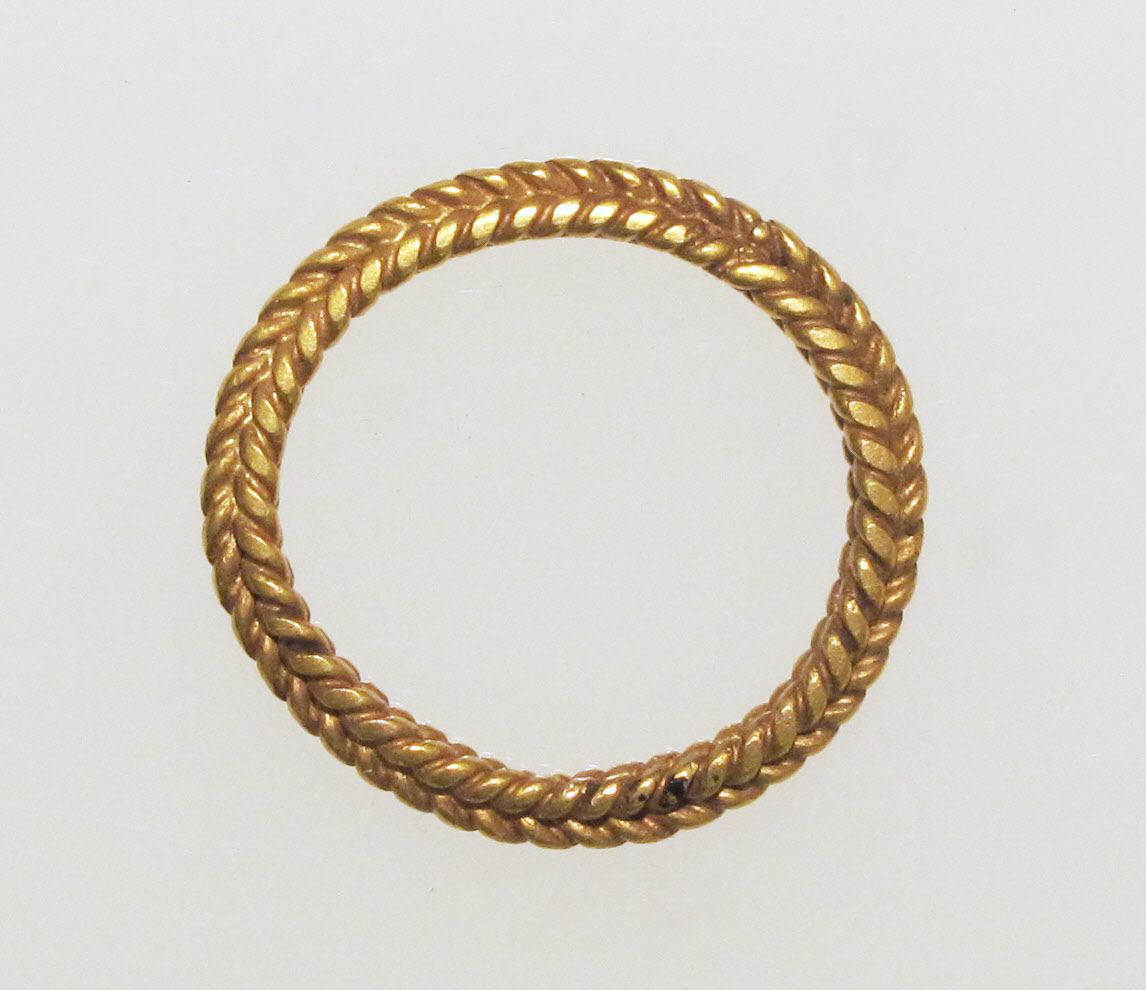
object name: ring, plaited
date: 7000 BCE-330 CE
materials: gold